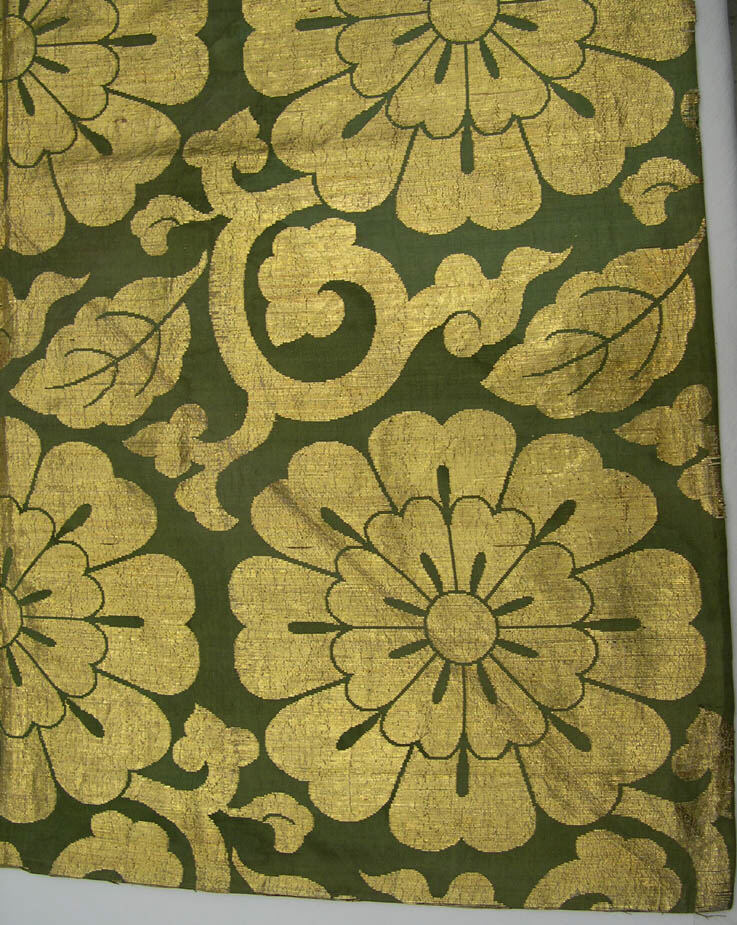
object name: altar cloth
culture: japanese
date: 1716-1736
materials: metal thread, silk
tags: flowers